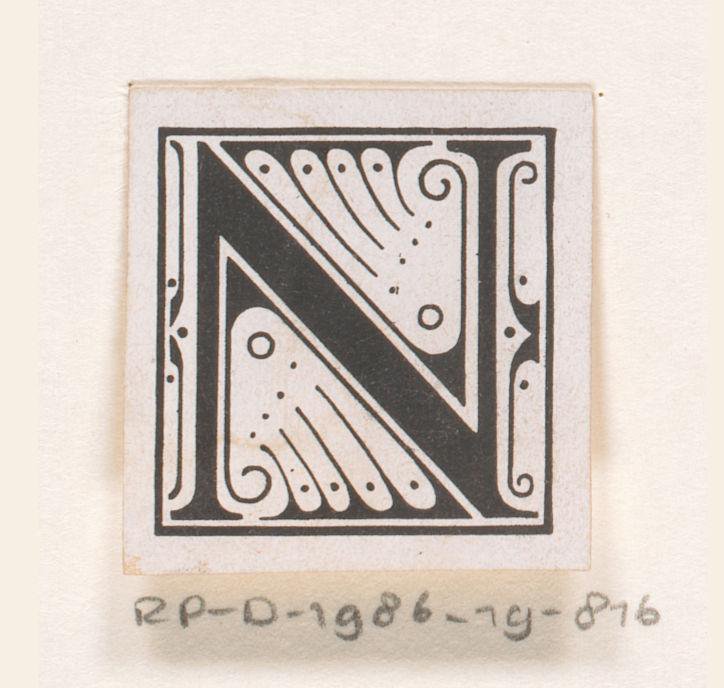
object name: photomechanical print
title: Initiaal N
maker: reinier willem petrus de vries (1874-1953)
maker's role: draughtsman, print maker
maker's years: 1874-1953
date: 1904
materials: paper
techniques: printing block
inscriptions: collector's mark: ‘R:MVS.’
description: Het initiaal is gebruikt voor: Veth, Jan. Jozef Israëls en zijn kunst. Arnhem en Nijmegen: Gebroeders E&M Cohen, 1904.